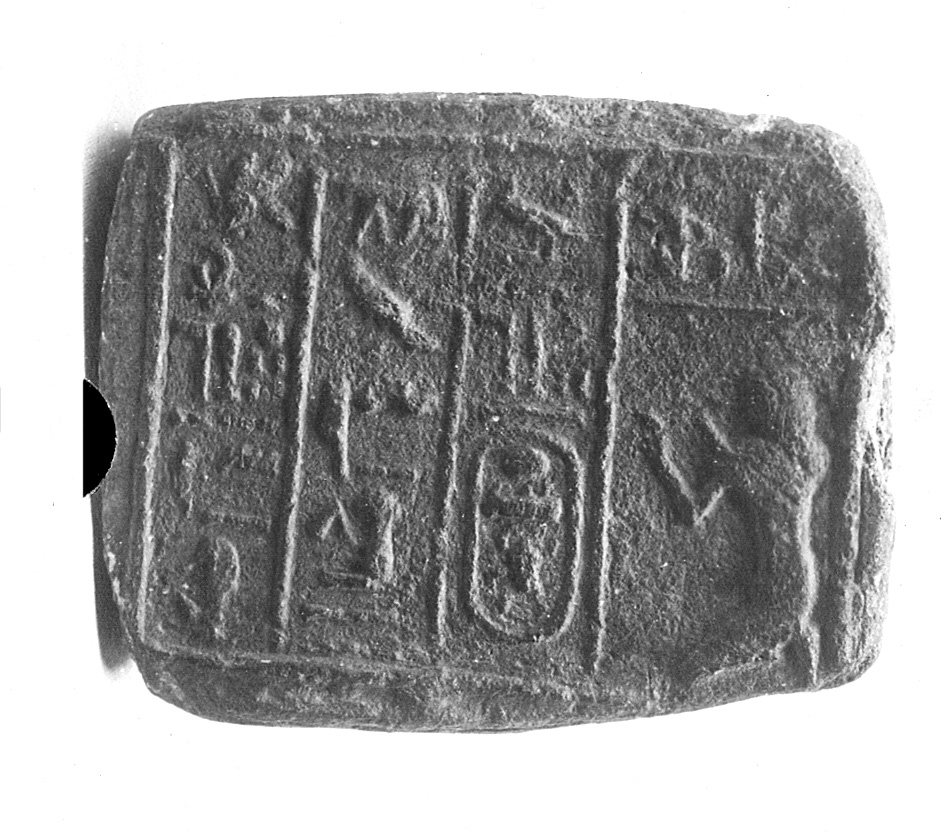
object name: cone, rectangular impression, kaemamun, prophet of amun, sikednu, thutmose iii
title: Funerary Cone of the Fourth Prophet of Amun Kaemamun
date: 1550-1295 BCE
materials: pottery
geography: egypt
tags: hieroglyphs